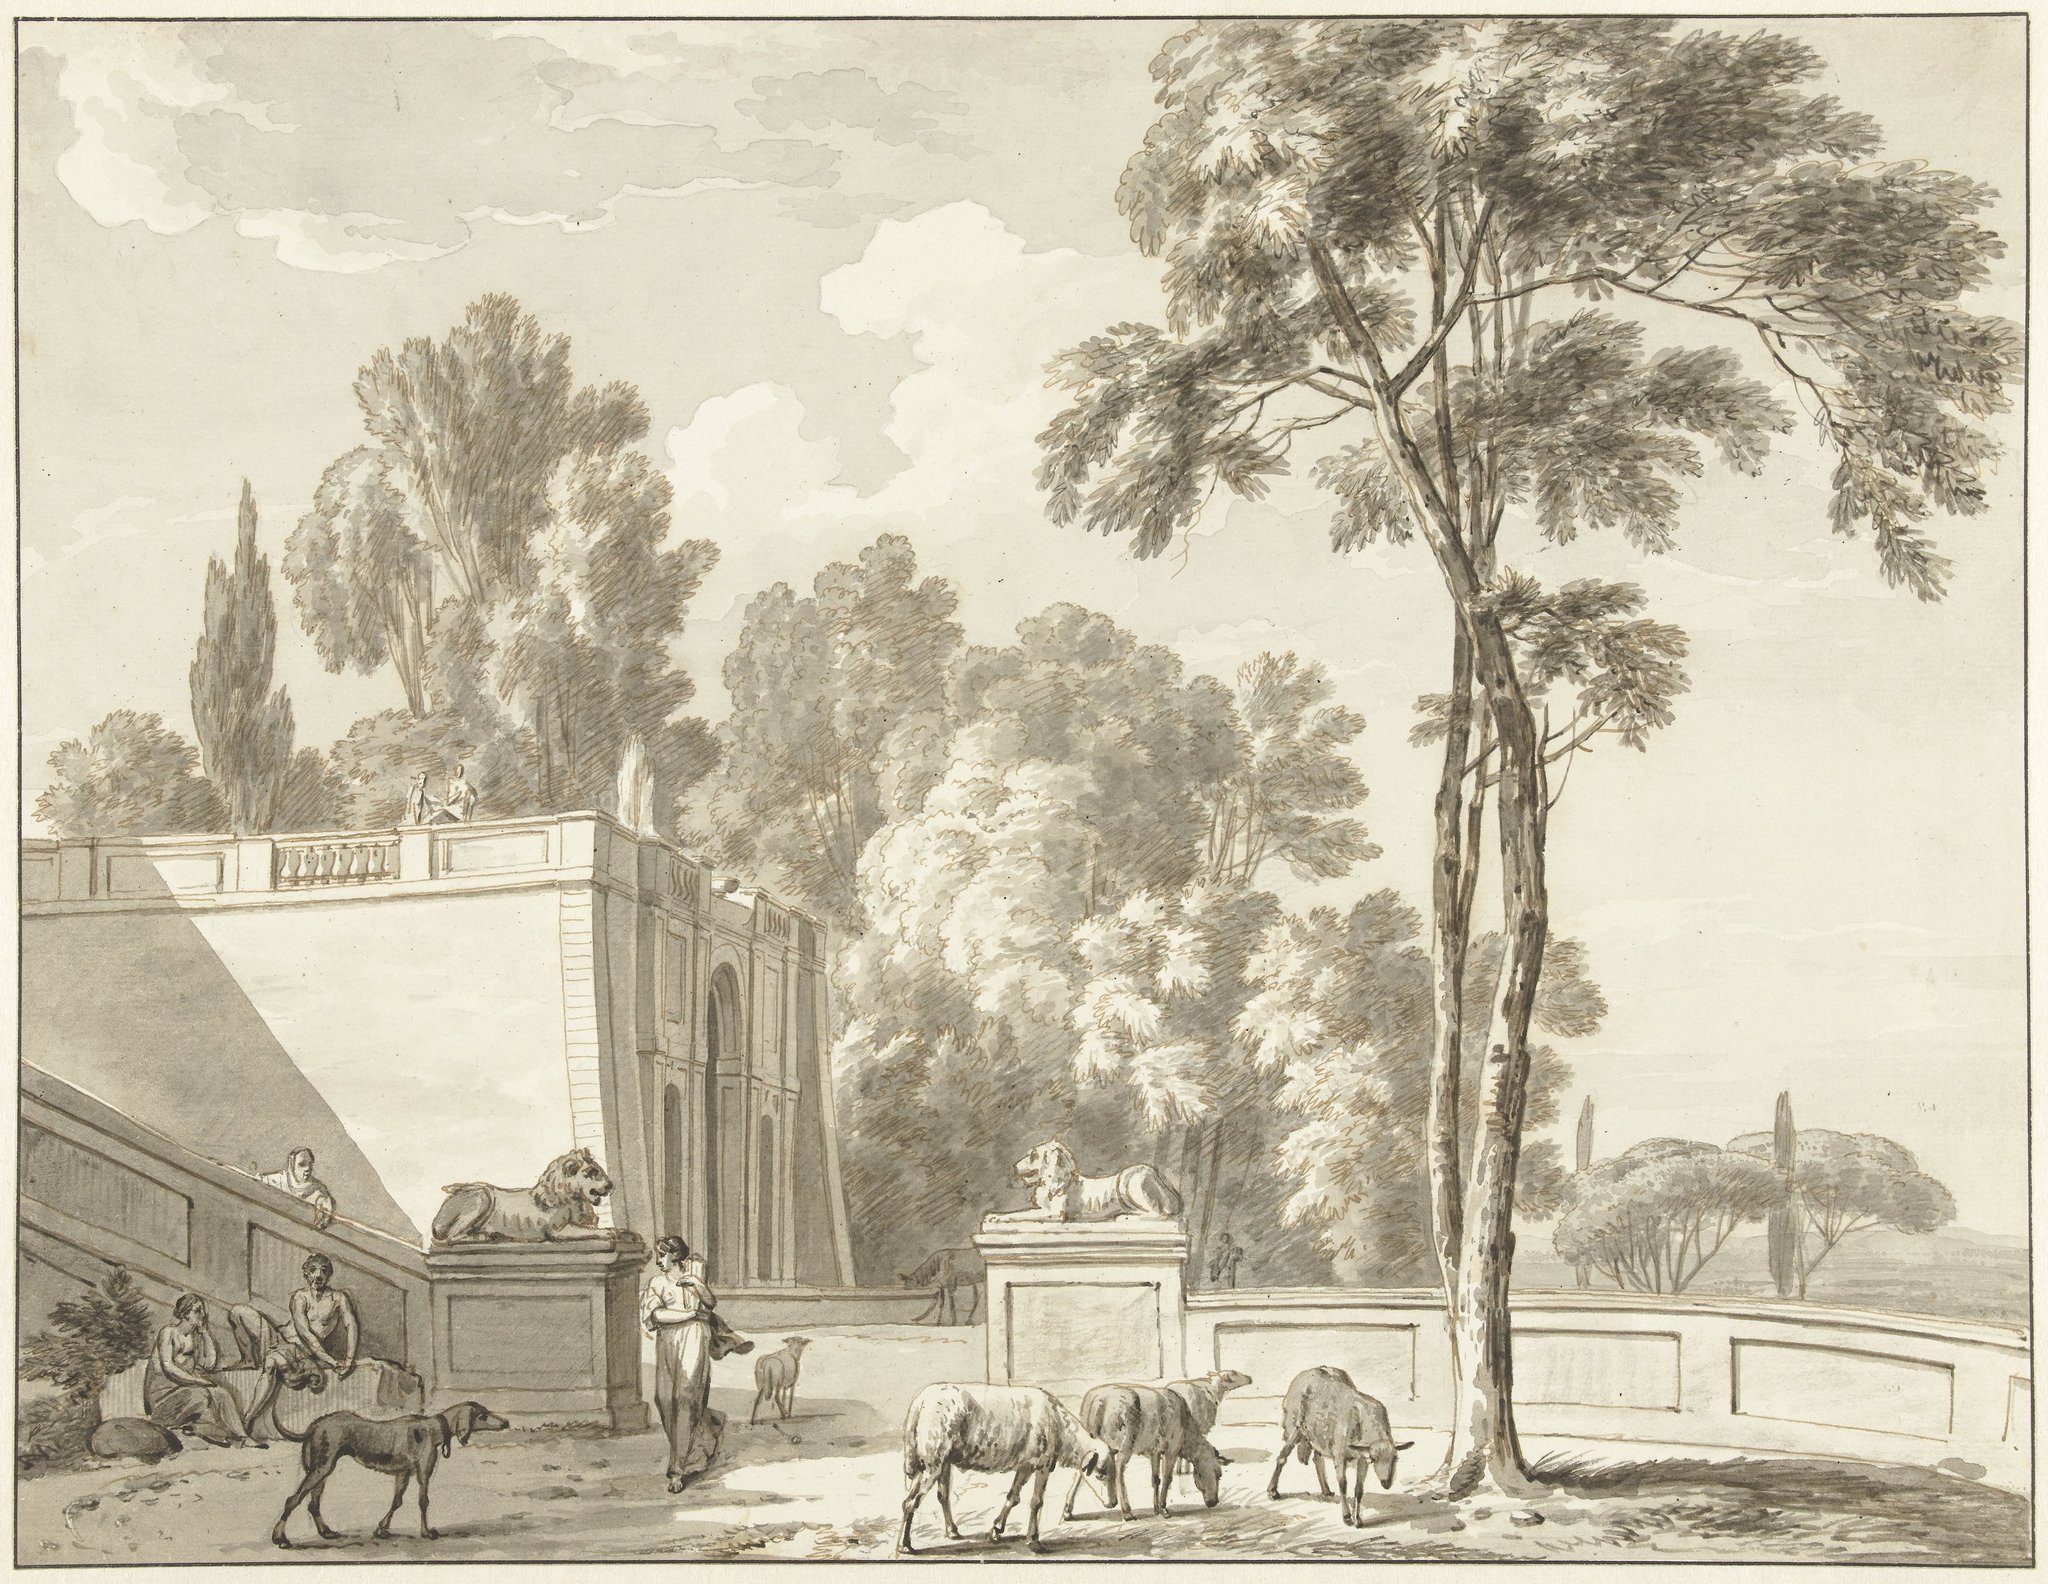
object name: drawing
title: Gezicht op terrassen bij de Villa Aldobrandini te Frascati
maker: jean grandjean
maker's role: draughtsman, print maker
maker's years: 1752-1781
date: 1779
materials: chalk, ink, paper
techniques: brush, pen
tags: villa, italy